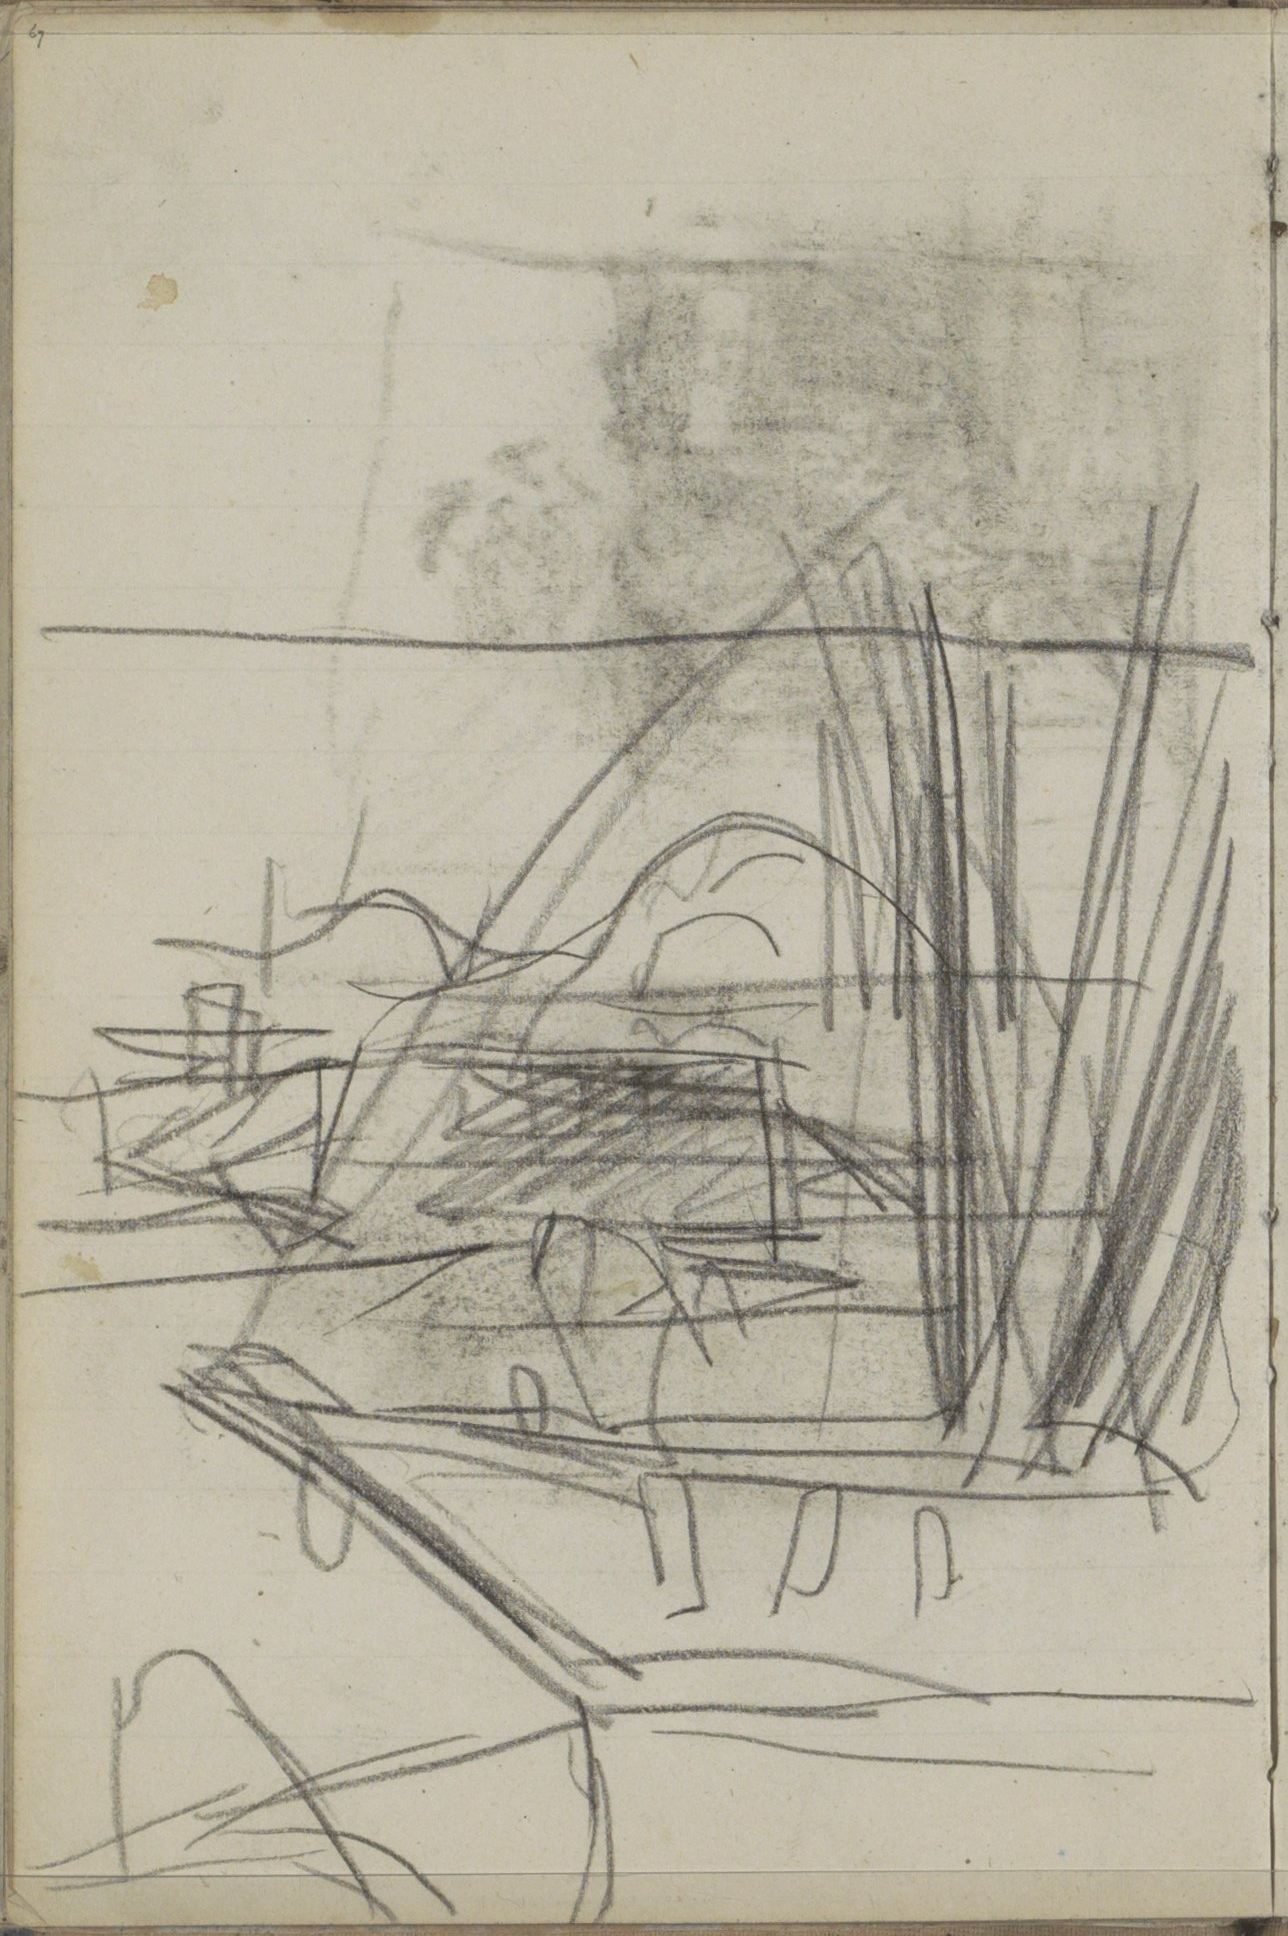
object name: sketchbook leaf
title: Studieblad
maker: marius bauer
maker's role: draughtsman, print maker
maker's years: 1867-1932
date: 1888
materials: chalk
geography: istanbul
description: Pagina 67 uit een schetsboek met 58 bladen.